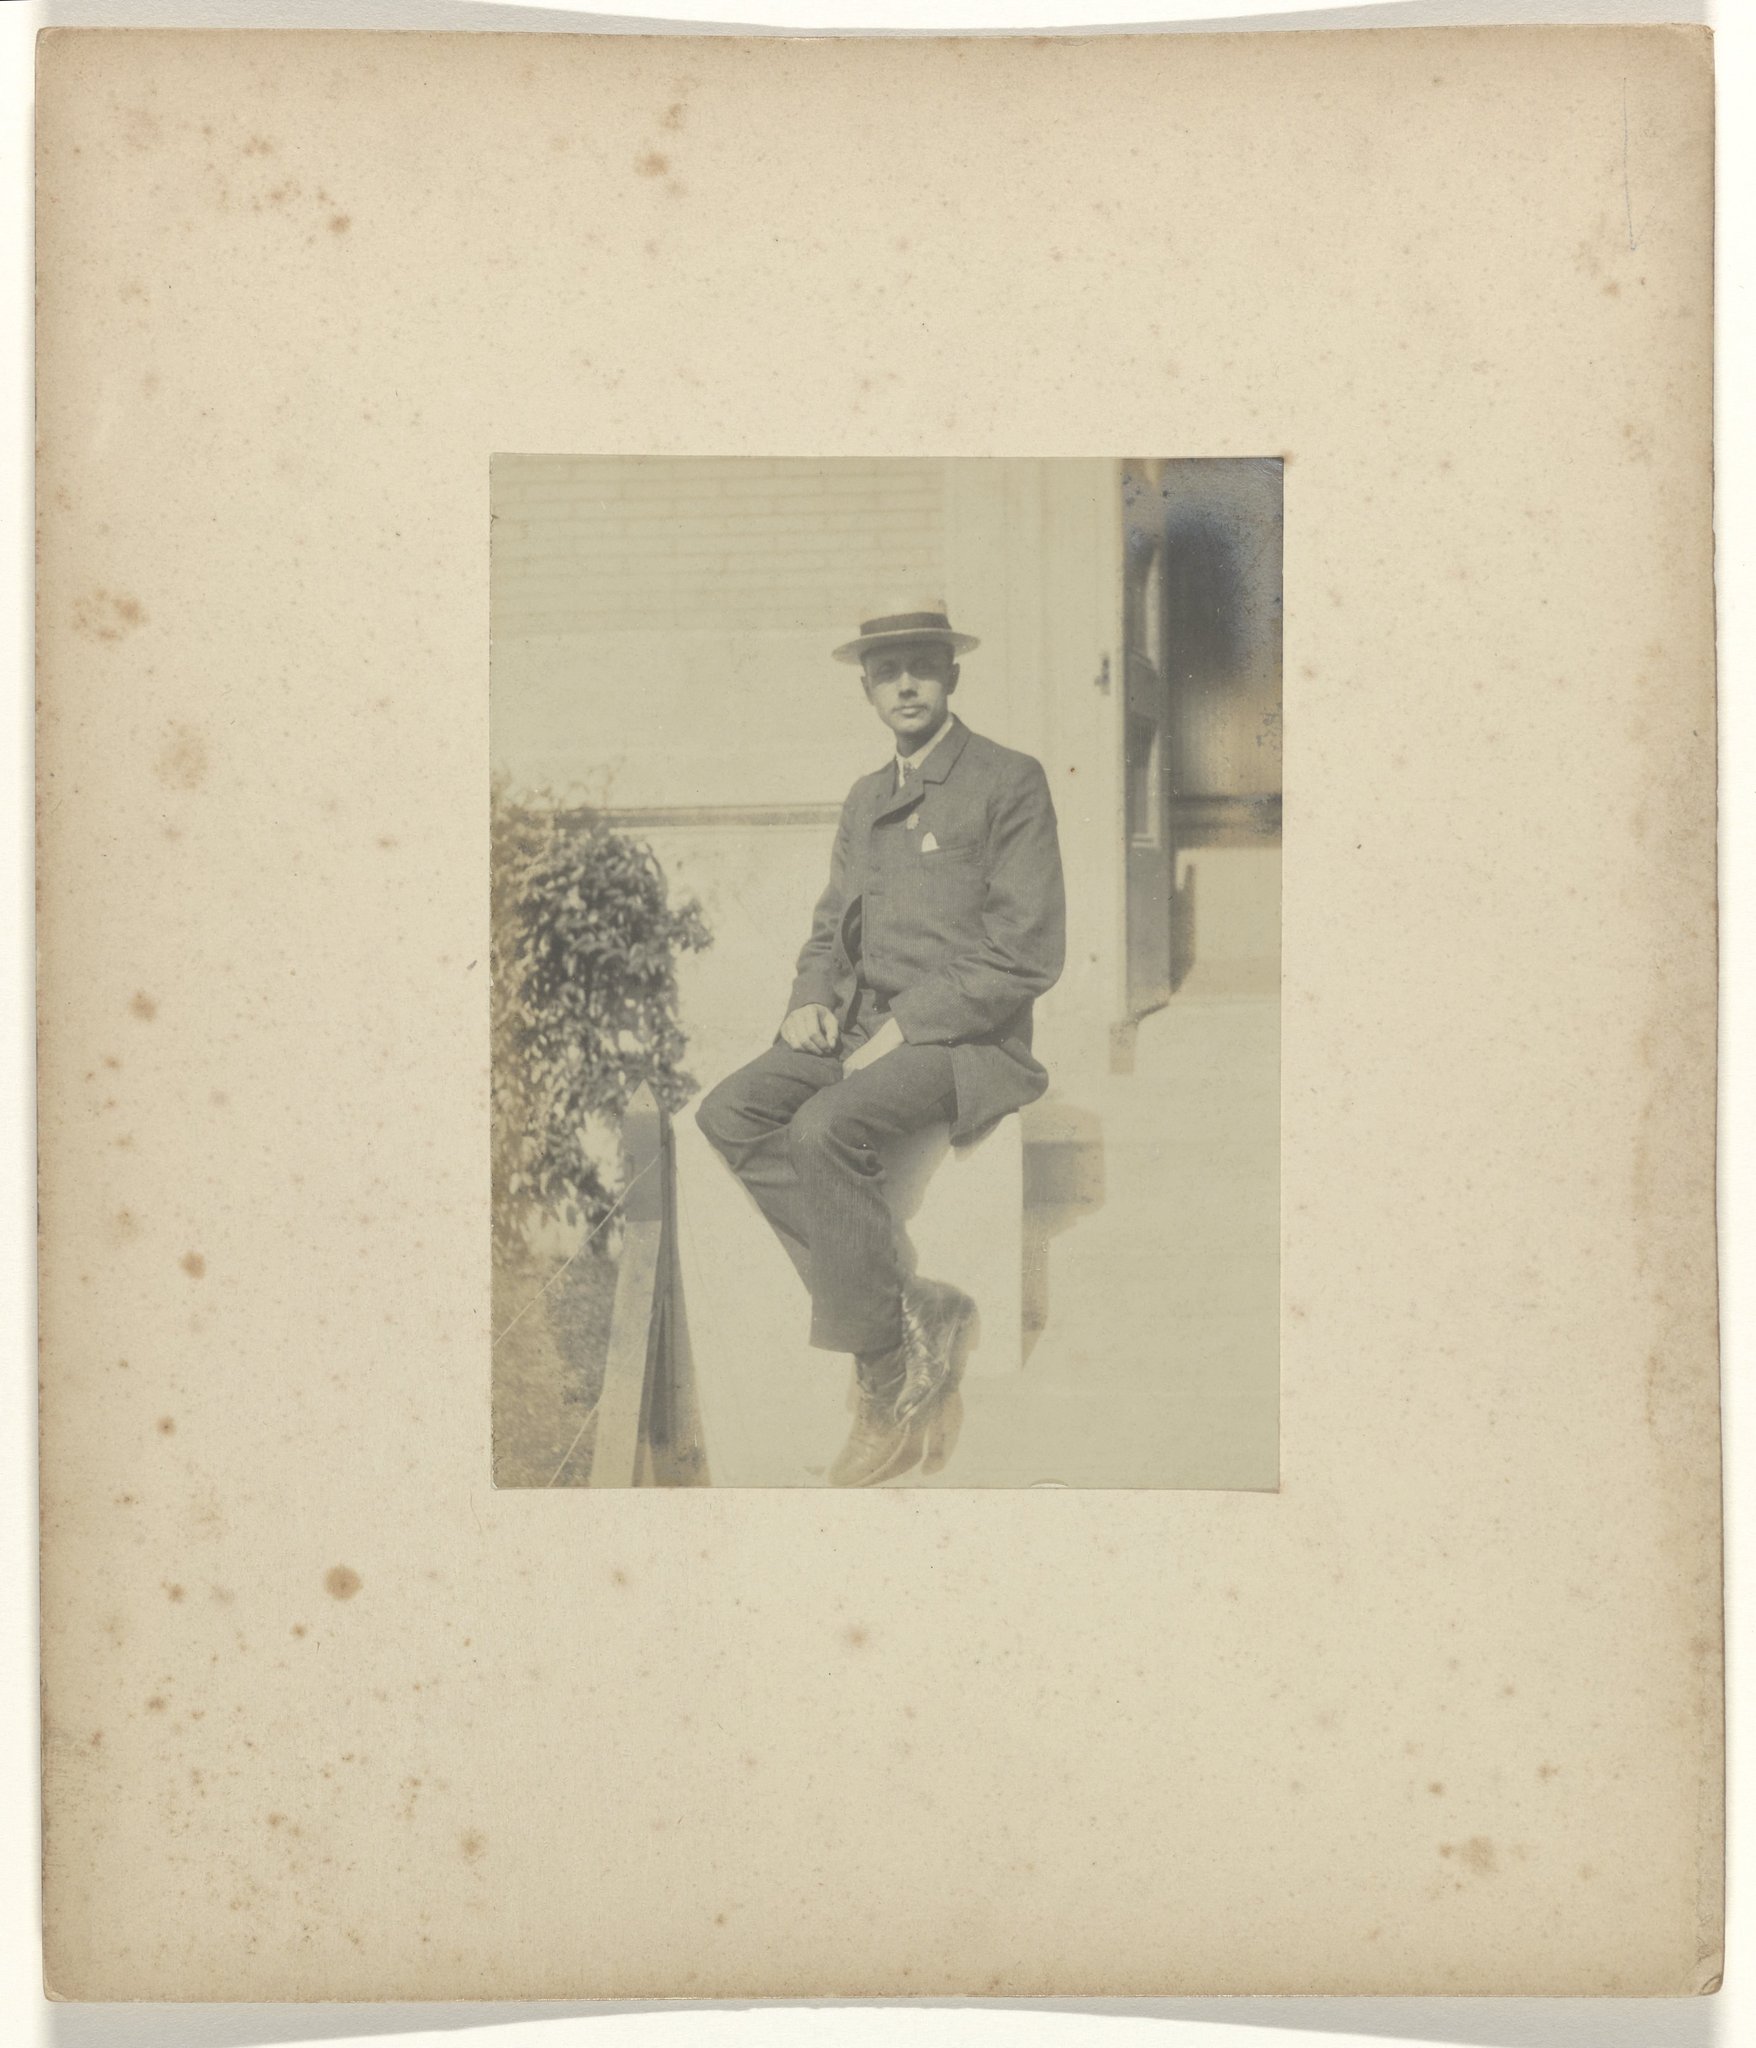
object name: photograph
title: Portret van Jan Catharinus Schüller (1871-1915)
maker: Anonymous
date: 1904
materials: cardboard, paper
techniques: gelatin silver print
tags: painter, print maker, draughtsman, jan schüller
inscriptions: annotation: ‘The Jura badge!’, annotation: ‘Jan C. Schüller’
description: Portret van Jan Catharinus Schüller (1871-1915), kunsthandelaar en vertegenwoordiger van de Nederlandse kunsthandelaren op de wereldtentoonstelling in St. Louis (Louisiana Purchase Exposition), 1904.